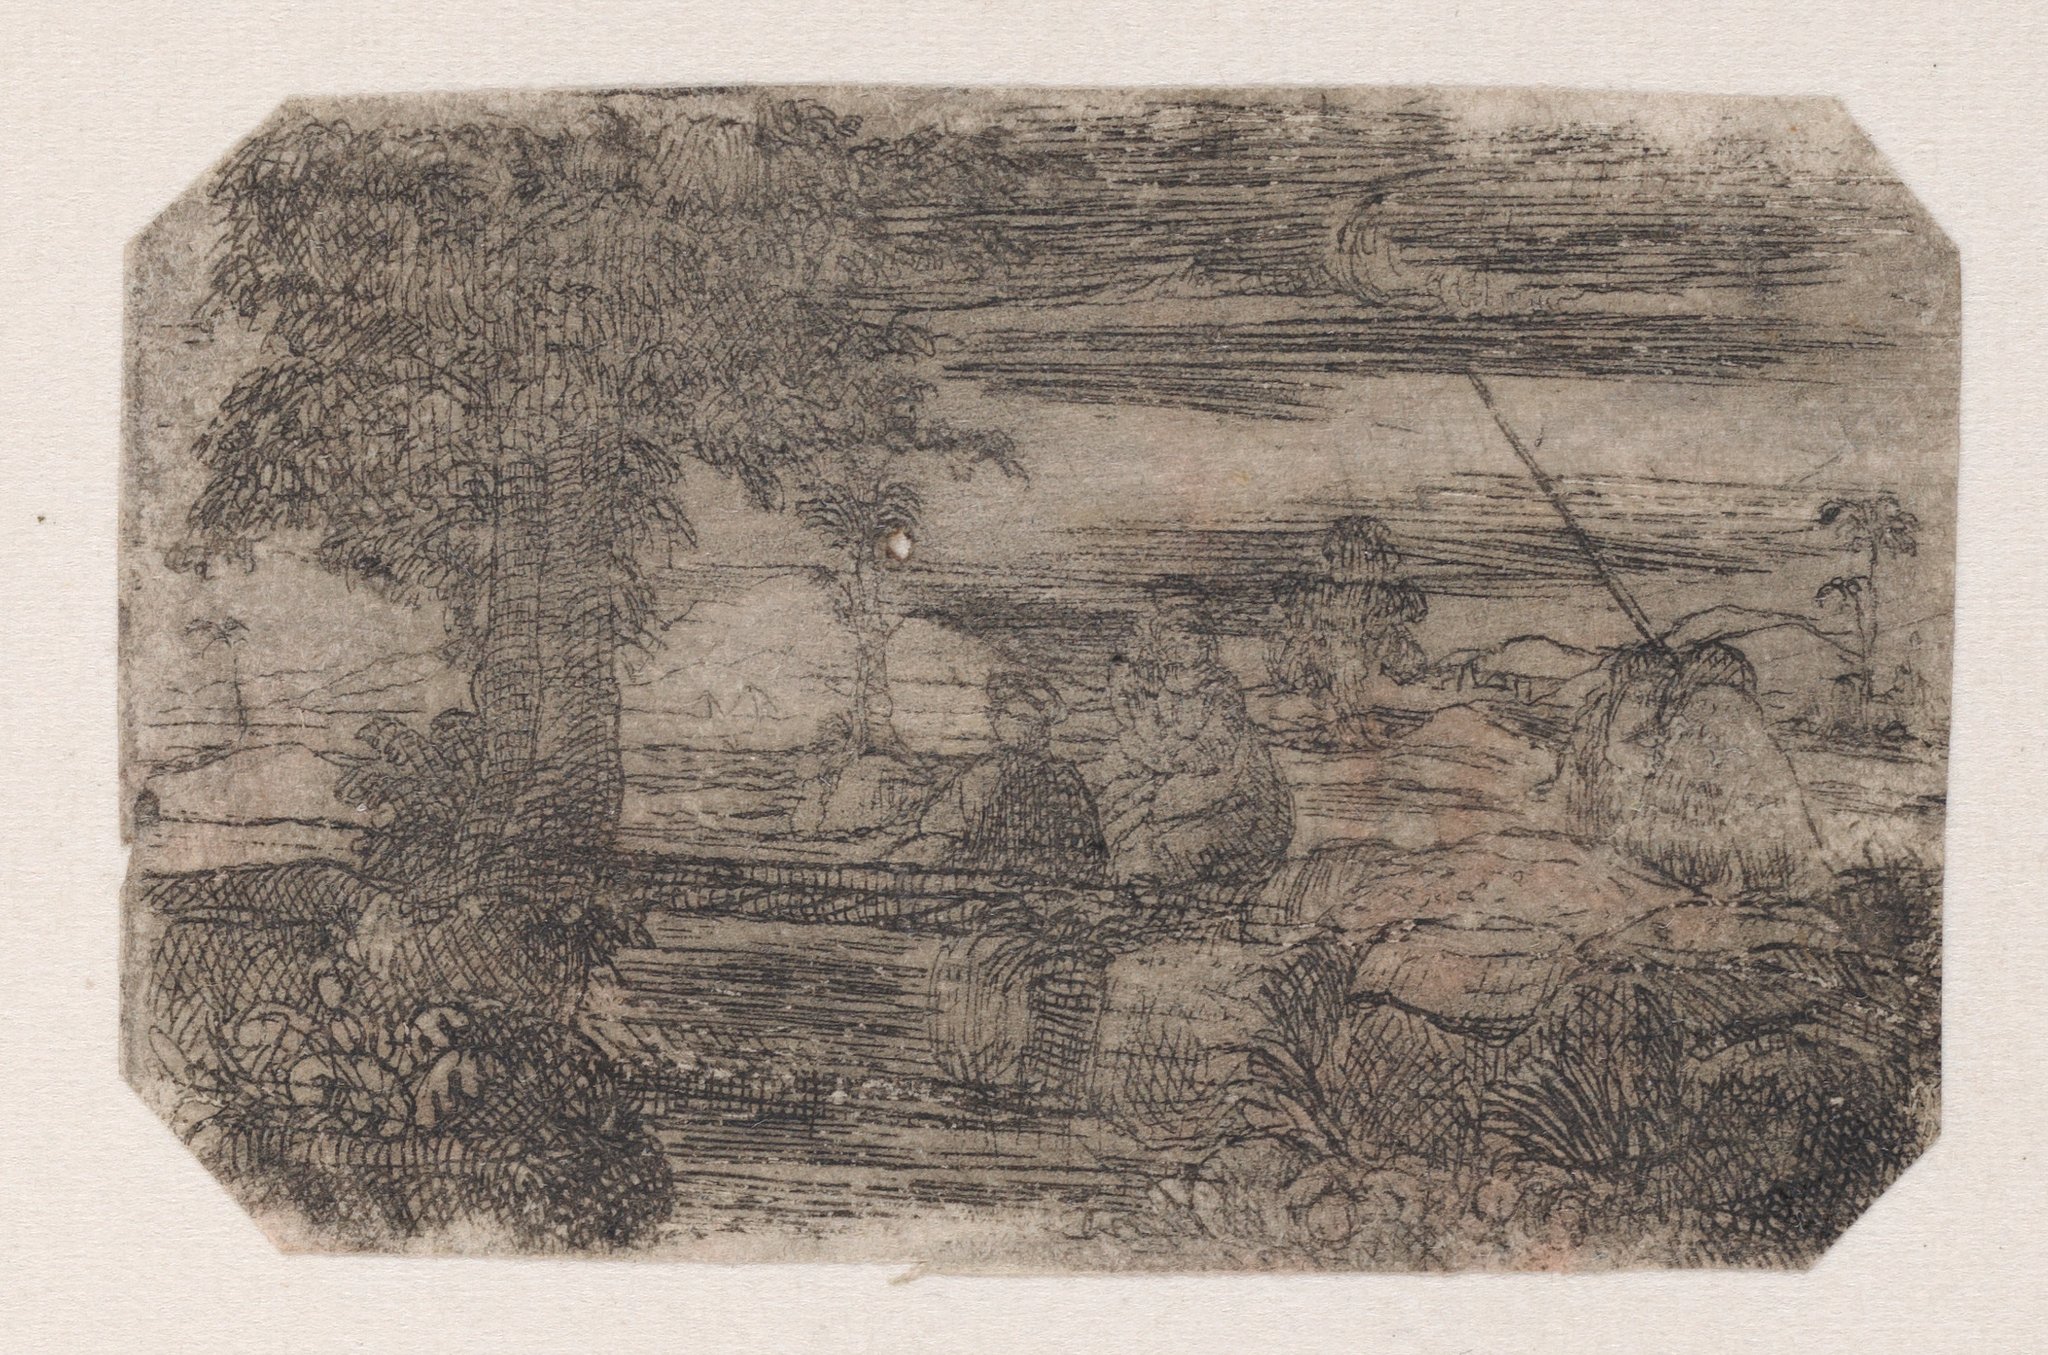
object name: print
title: La Sainte Famille au Repos (The Holy Family at Rest)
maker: rodolphe bresdin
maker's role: artist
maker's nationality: french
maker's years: 1822-1885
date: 1801-1900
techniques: etching